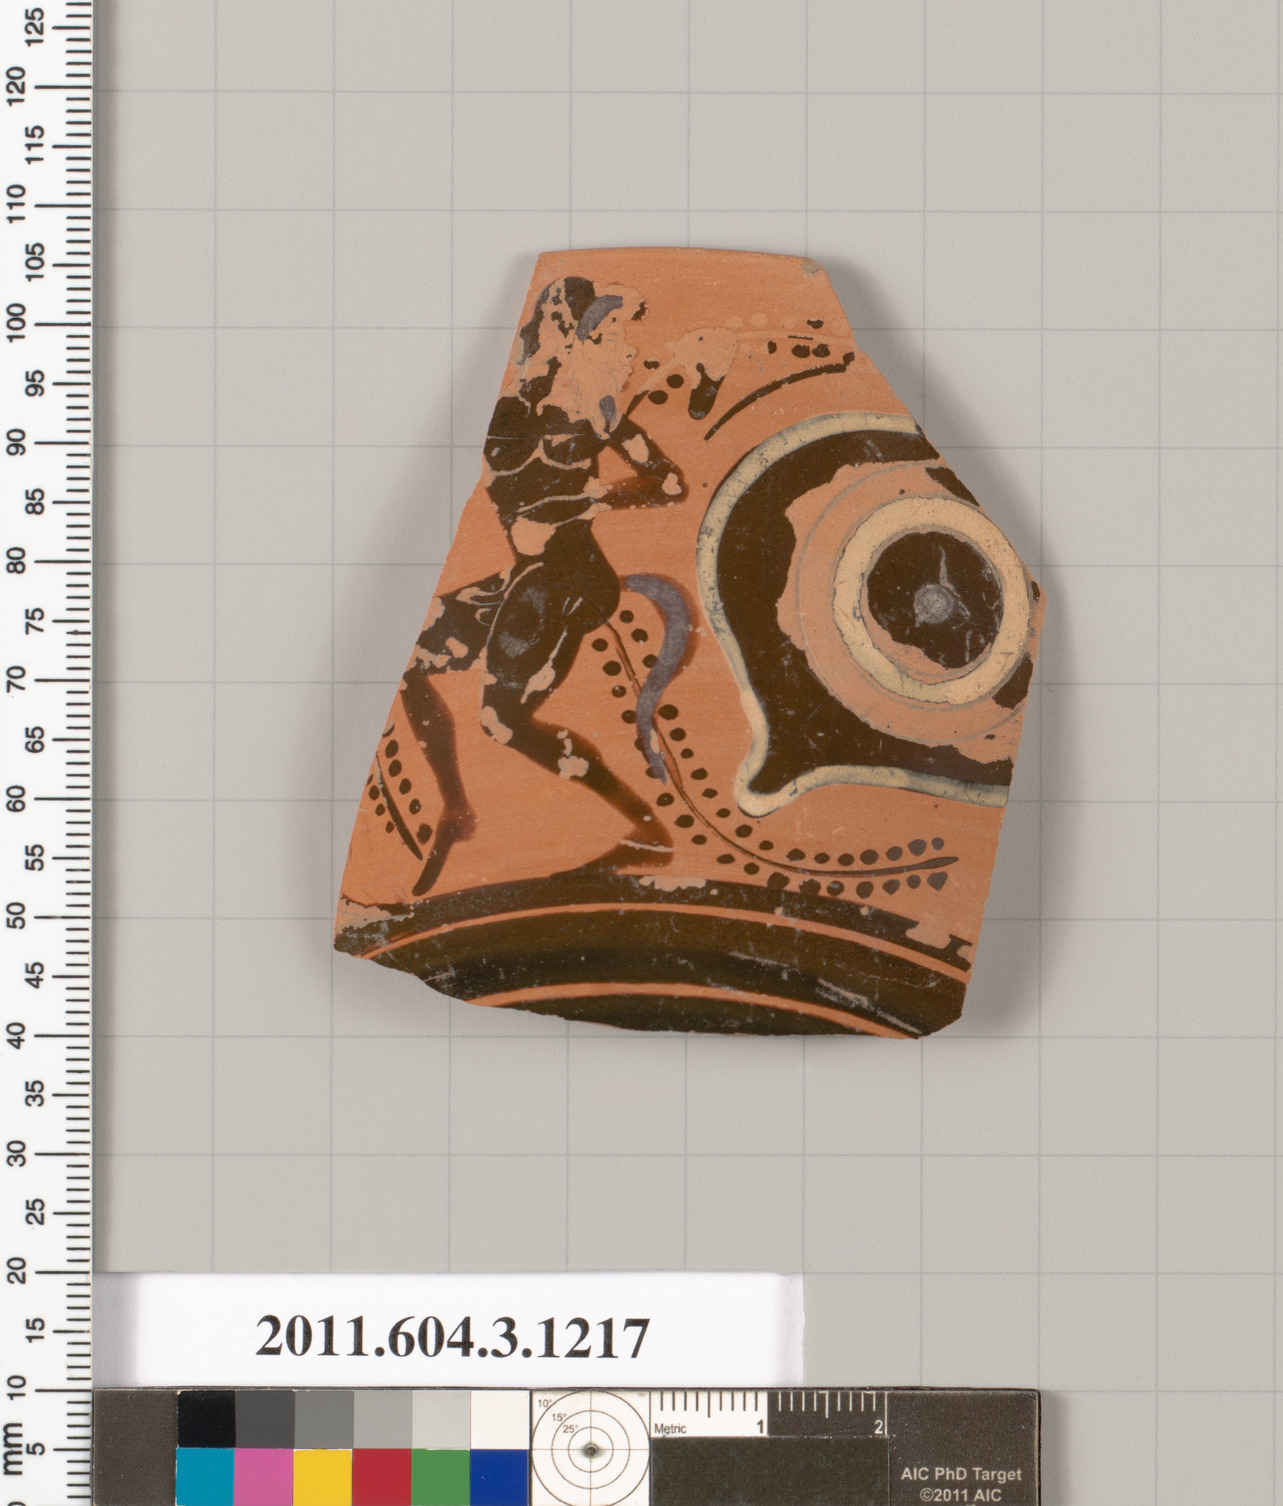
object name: kyathos fragment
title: Terracotta rim fragment of a kyathos (cup-shaped ladle)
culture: greek, attic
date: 534-468 BCE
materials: terracotta